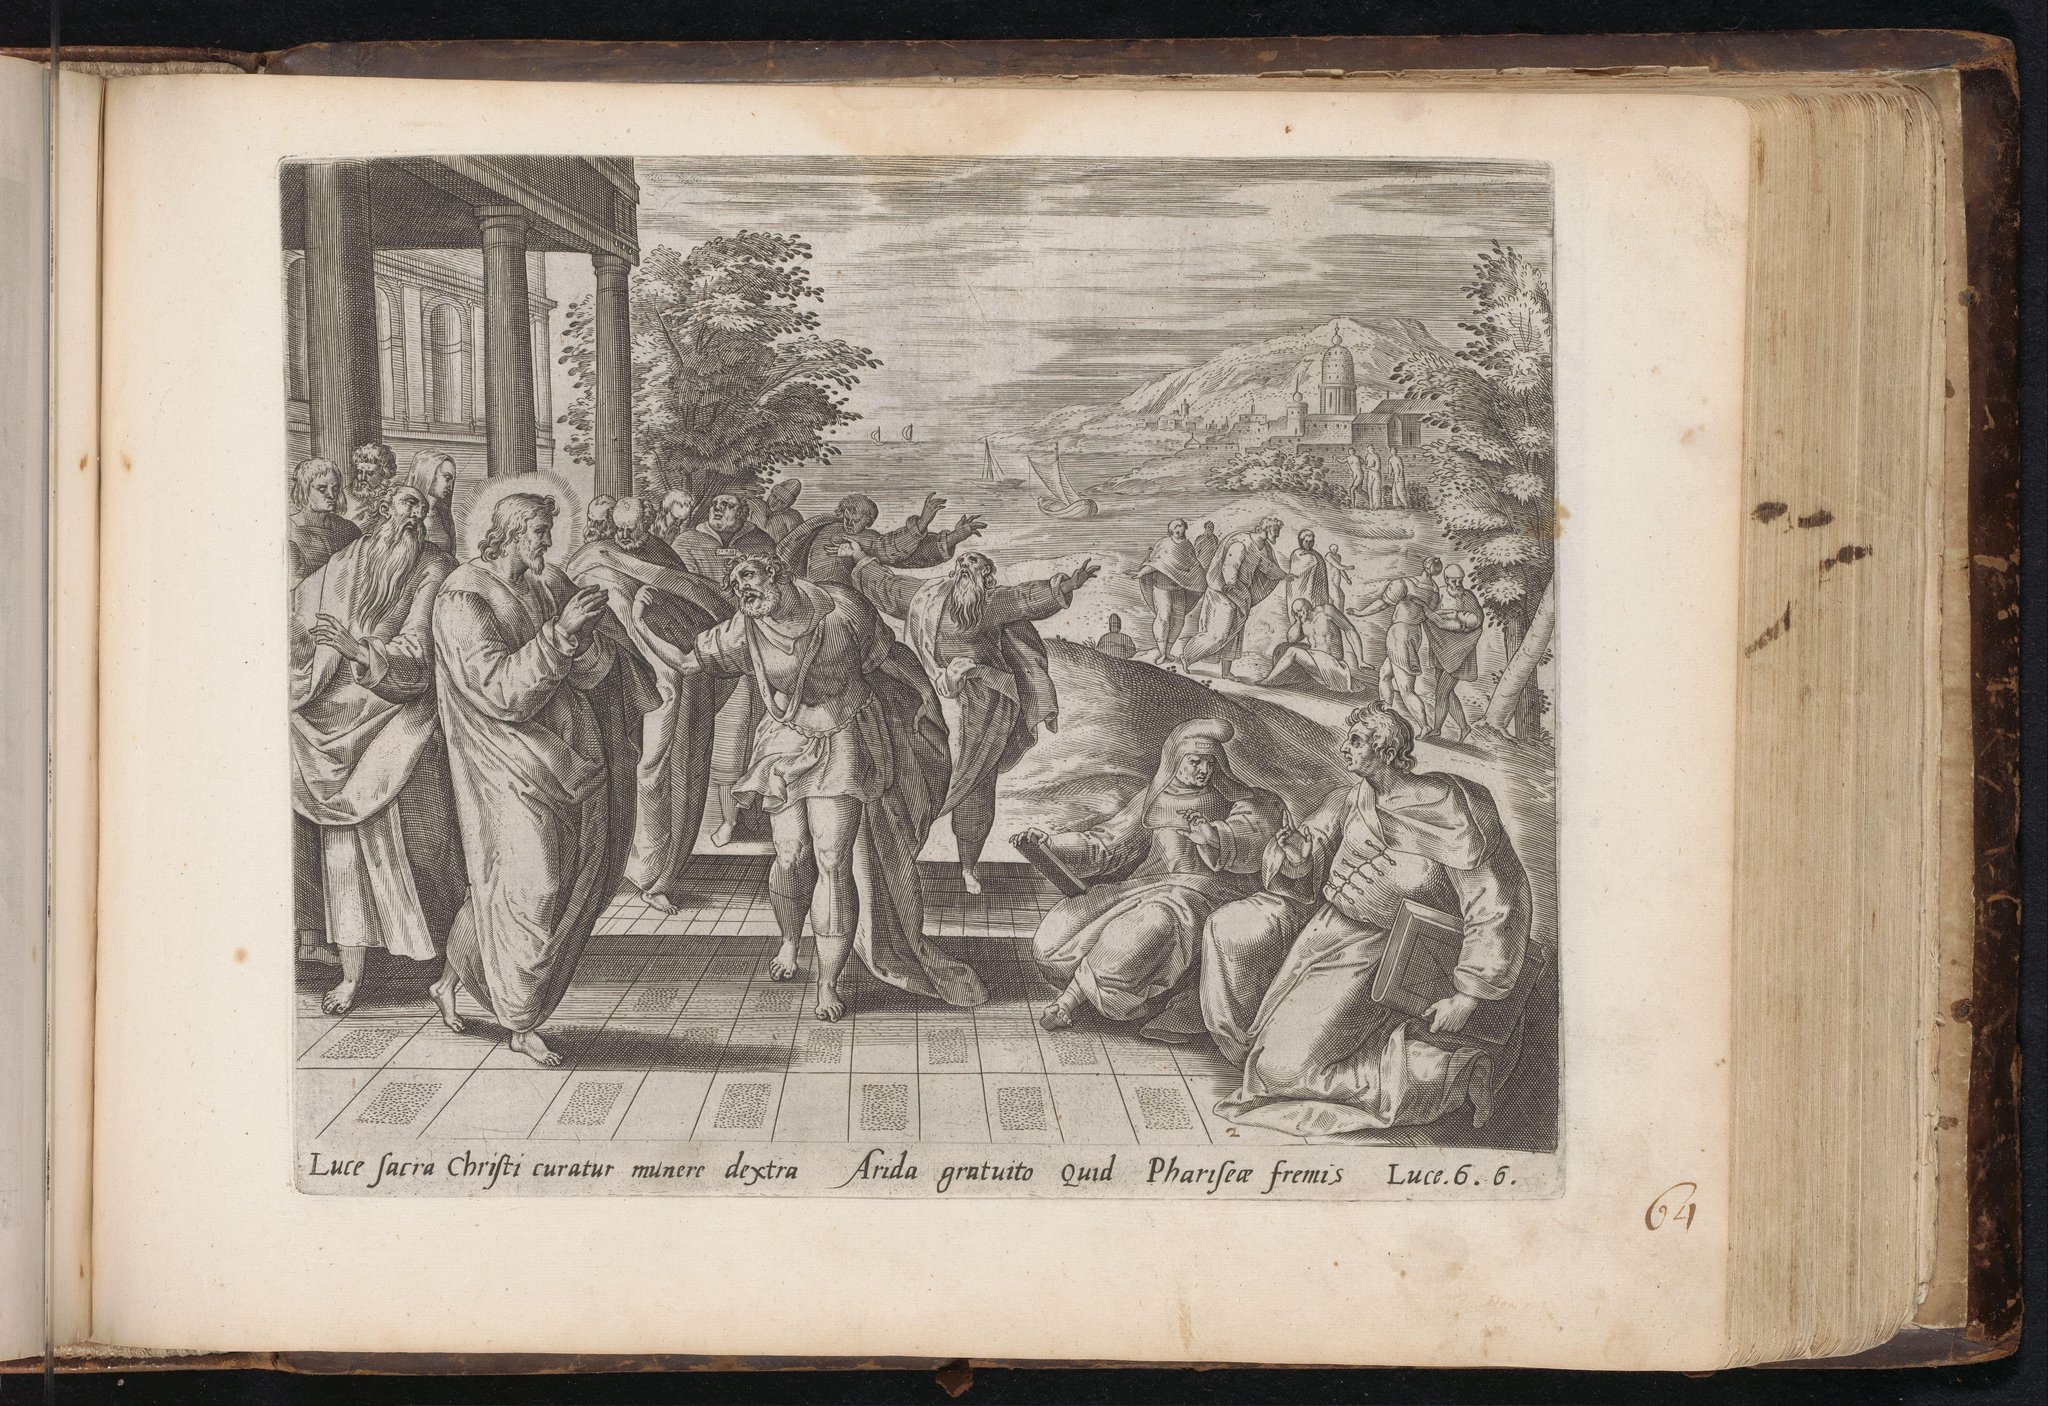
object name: print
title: Den Grooten Figuer-Bibel (...)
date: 1572-1576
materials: paper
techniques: engraving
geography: alkmaar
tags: healing of a man with a withered hand (matthew 12:9-13; mark 3:1-5; luke 6:6-10)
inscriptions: number: ‘64’, serial number: ‘2’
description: Christus geneest bij de tempel op sabbat een man met een verschrompelde hand. De man strekt zijn hand uit naar Christus. De schriftgeleerden kijken toe. Twee van hen zitten op de grond met wetsboeken in de hand. Op de achtergrond in het landschap geneest Christus andere mensen. Onder de voorstelling een verwijzing in het Latijn naar de Bijbeltekst in Luc. 6:6. Deze prent maakt deel uit van een album.